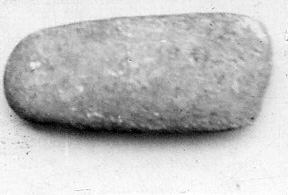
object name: pestle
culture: japanese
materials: stone